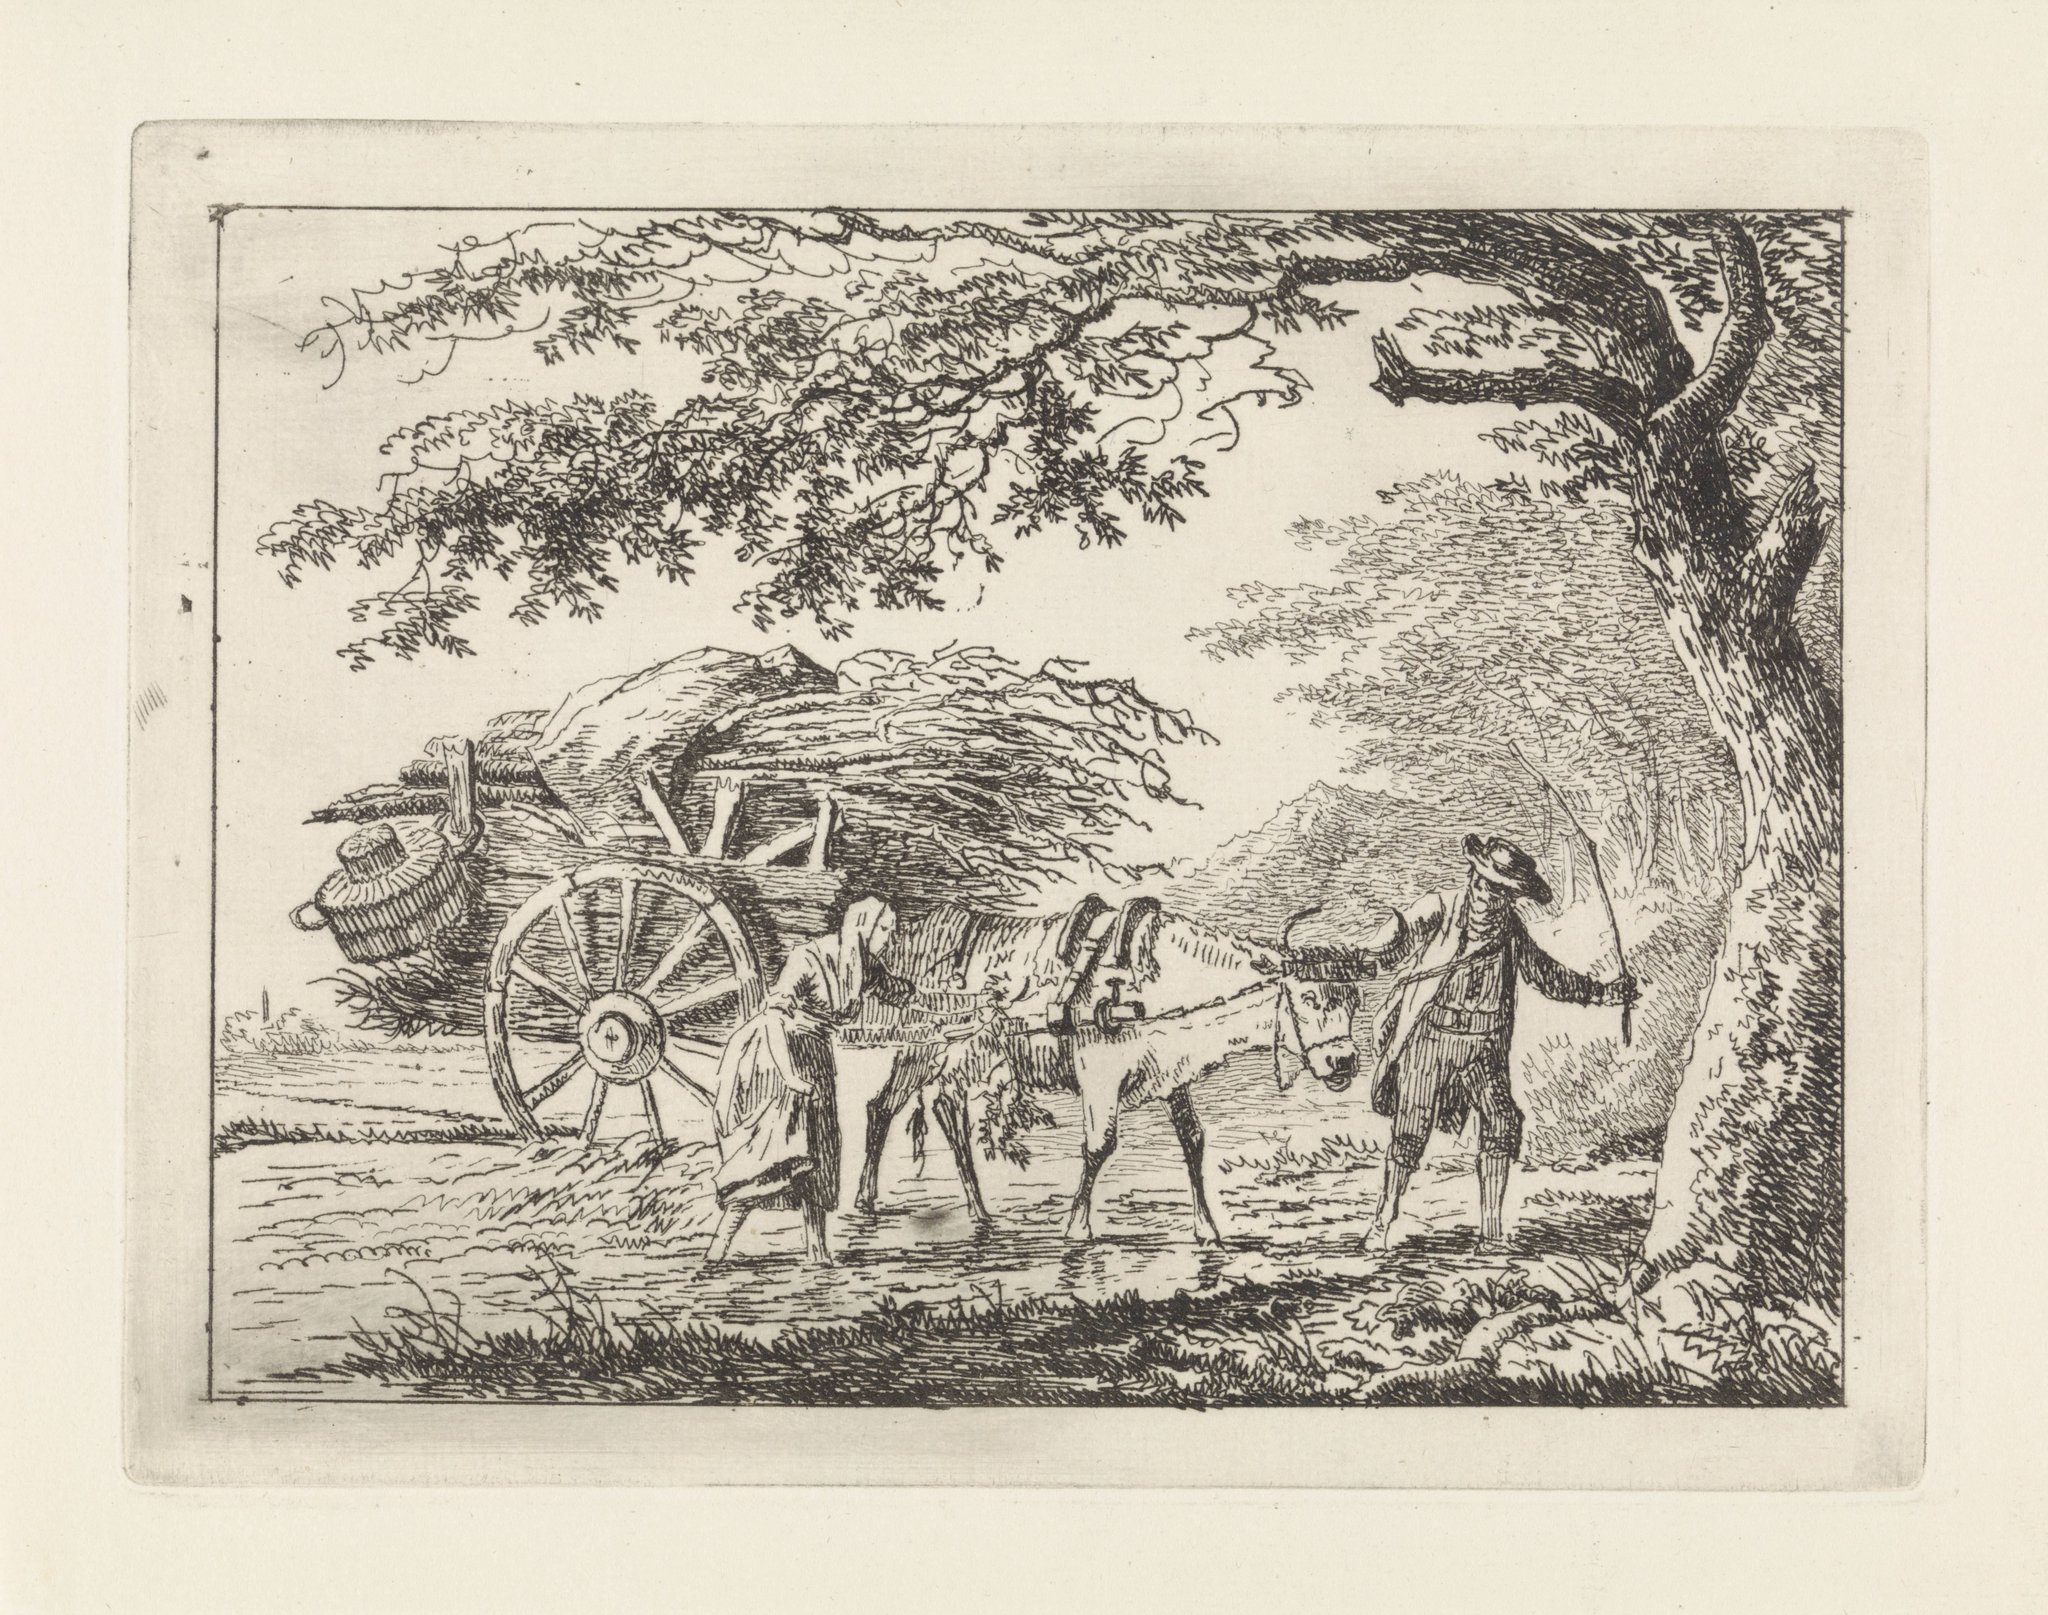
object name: print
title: Man en een vrouw bij een volgeladen ossenkar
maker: gerard van nijmegen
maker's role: draughtsman, painter, print maker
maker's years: 1735-1808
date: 1794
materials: paper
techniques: etching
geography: rotterdam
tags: ox, two-wheeled vehicle drawn by one animal, wading, paddling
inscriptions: collector's mark: Lugt 2228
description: Een man en een vrouw begeleiden een volgeladen ossenkar en waden daarmee door ondiep water.